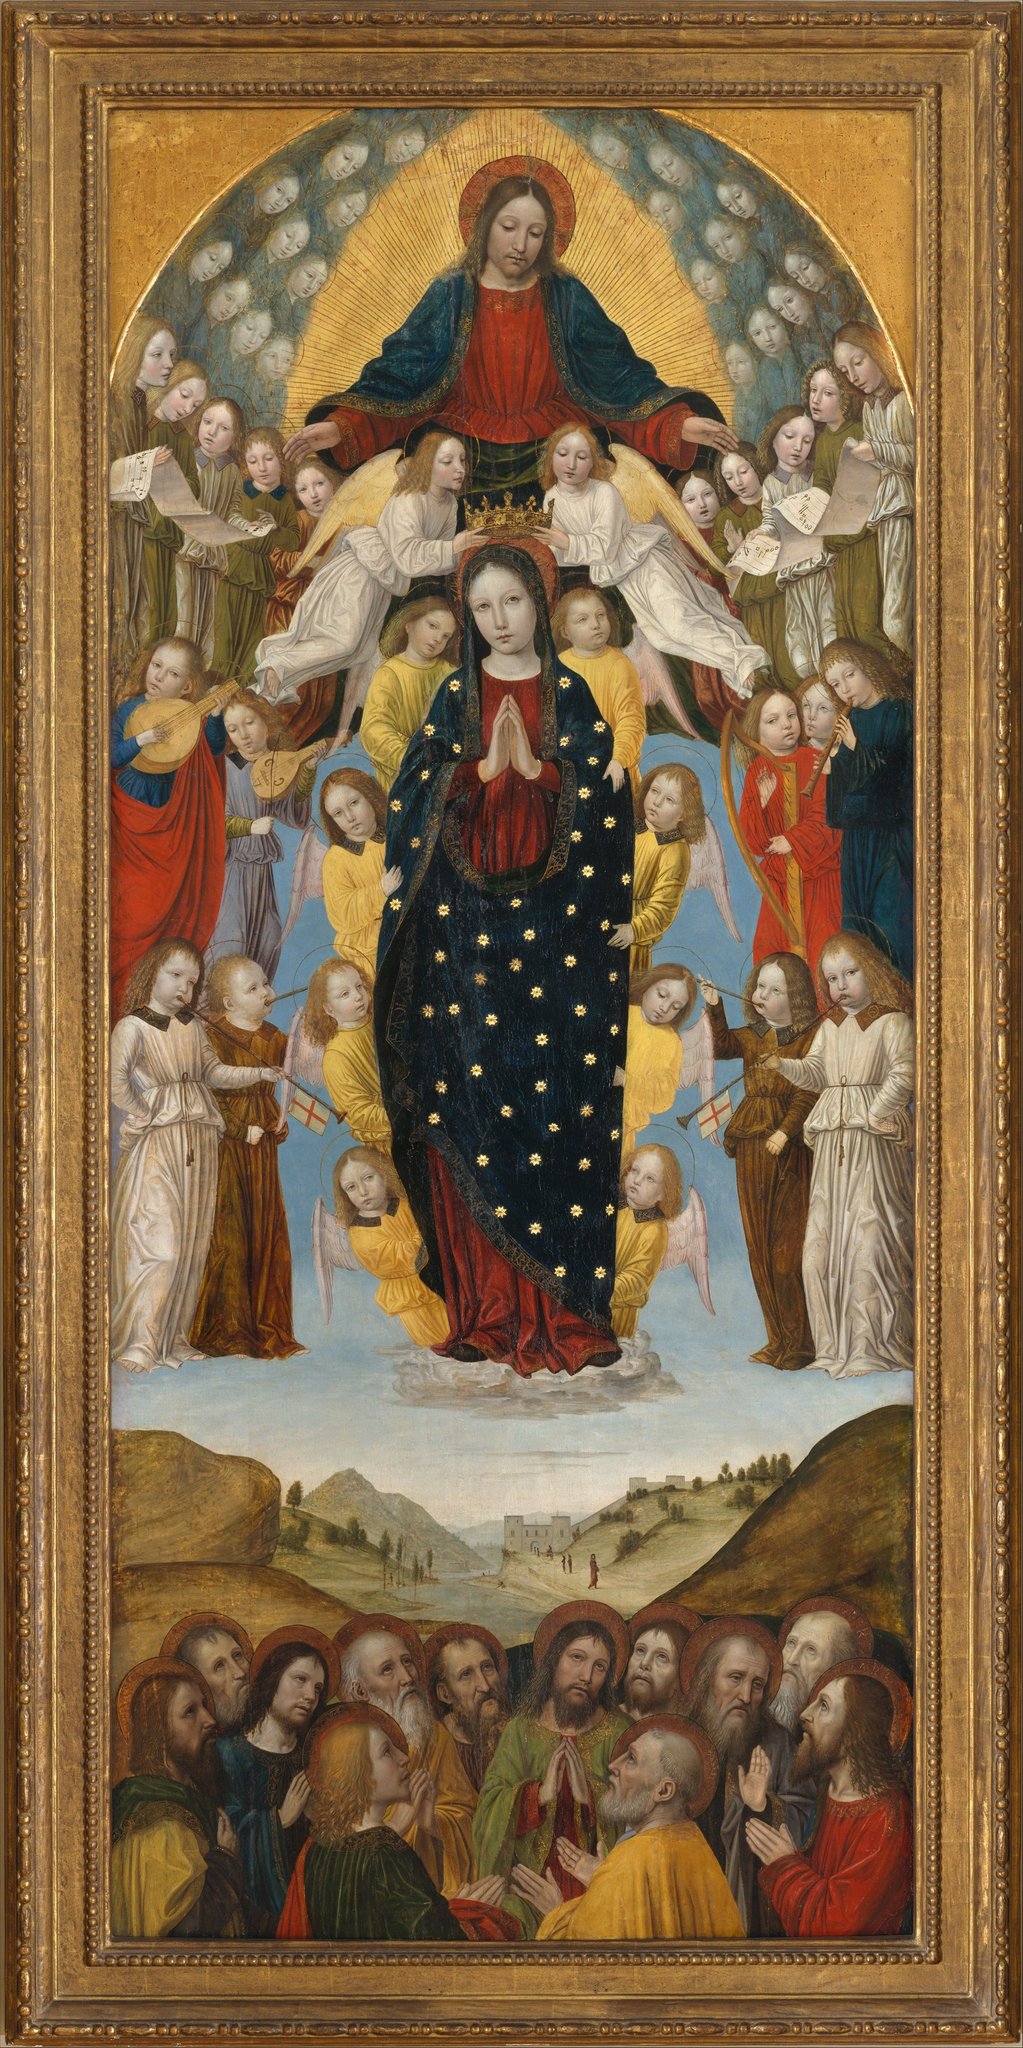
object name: painting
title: The Assumption of the Virgin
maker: bergognone (ambrogio di stefano da fossano)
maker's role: artist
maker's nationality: italian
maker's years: 1453-1523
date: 1500-1523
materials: gold, oil, wood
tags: angels,virgin mary,assumption of the virgin